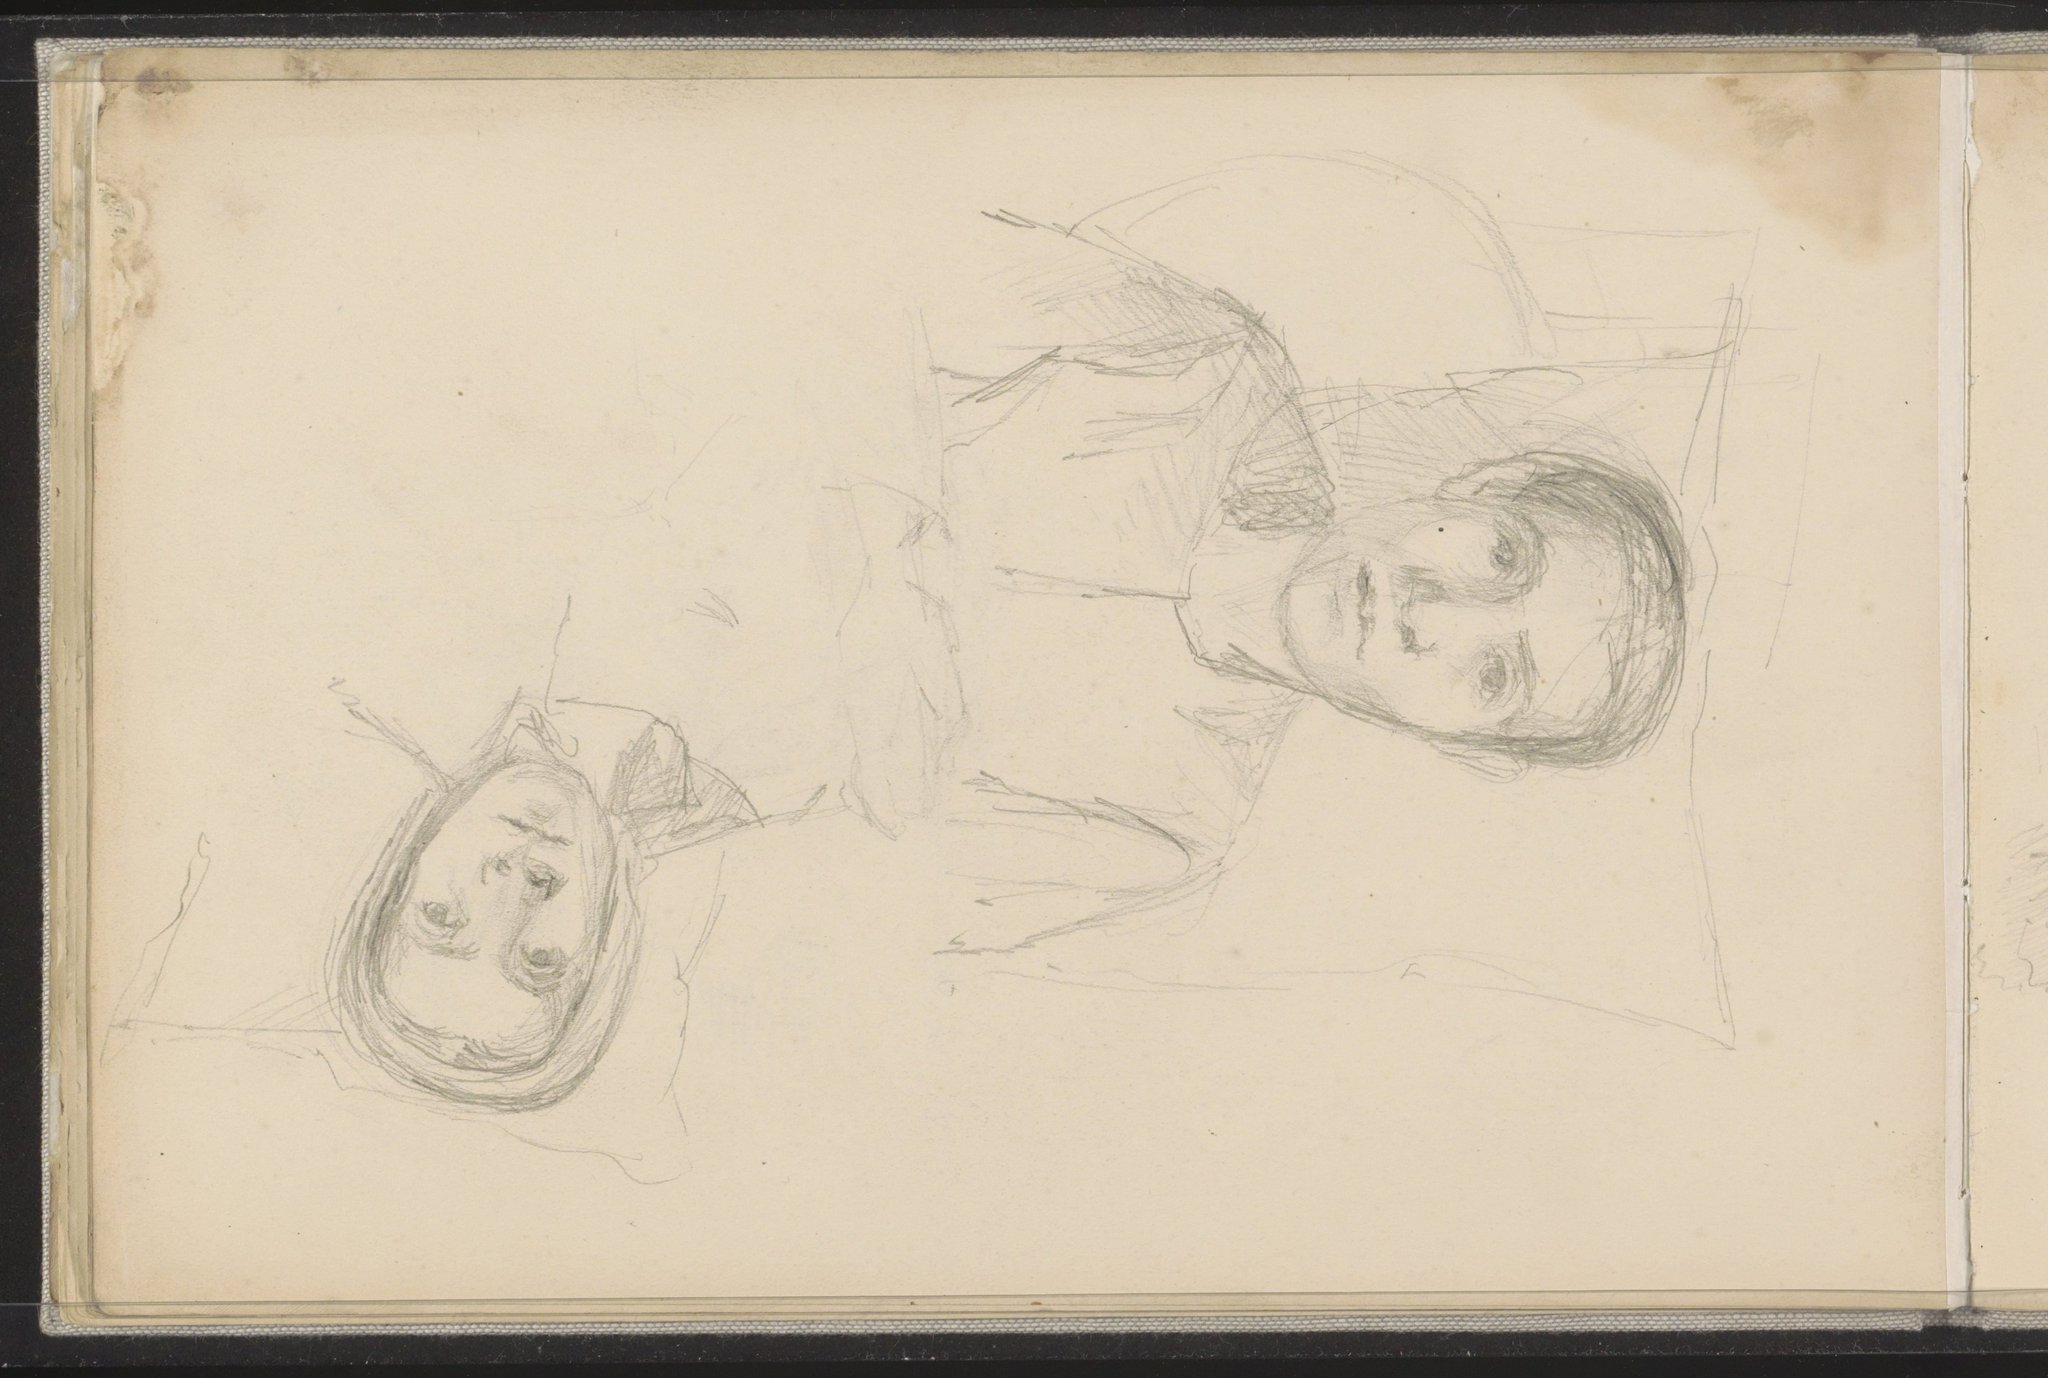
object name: sketchbook leaf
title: Kop van een man en een vrouw met een muts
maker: jozef israëls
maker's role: draughtsman, painter, print maker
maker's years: 1824-1911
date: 1834-1911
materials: paper, pencil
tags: head (human)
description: Achter de koppen vermoedelijk hoofdkussens. Blad 21 verso uit een schetsboek met 30 bladen.